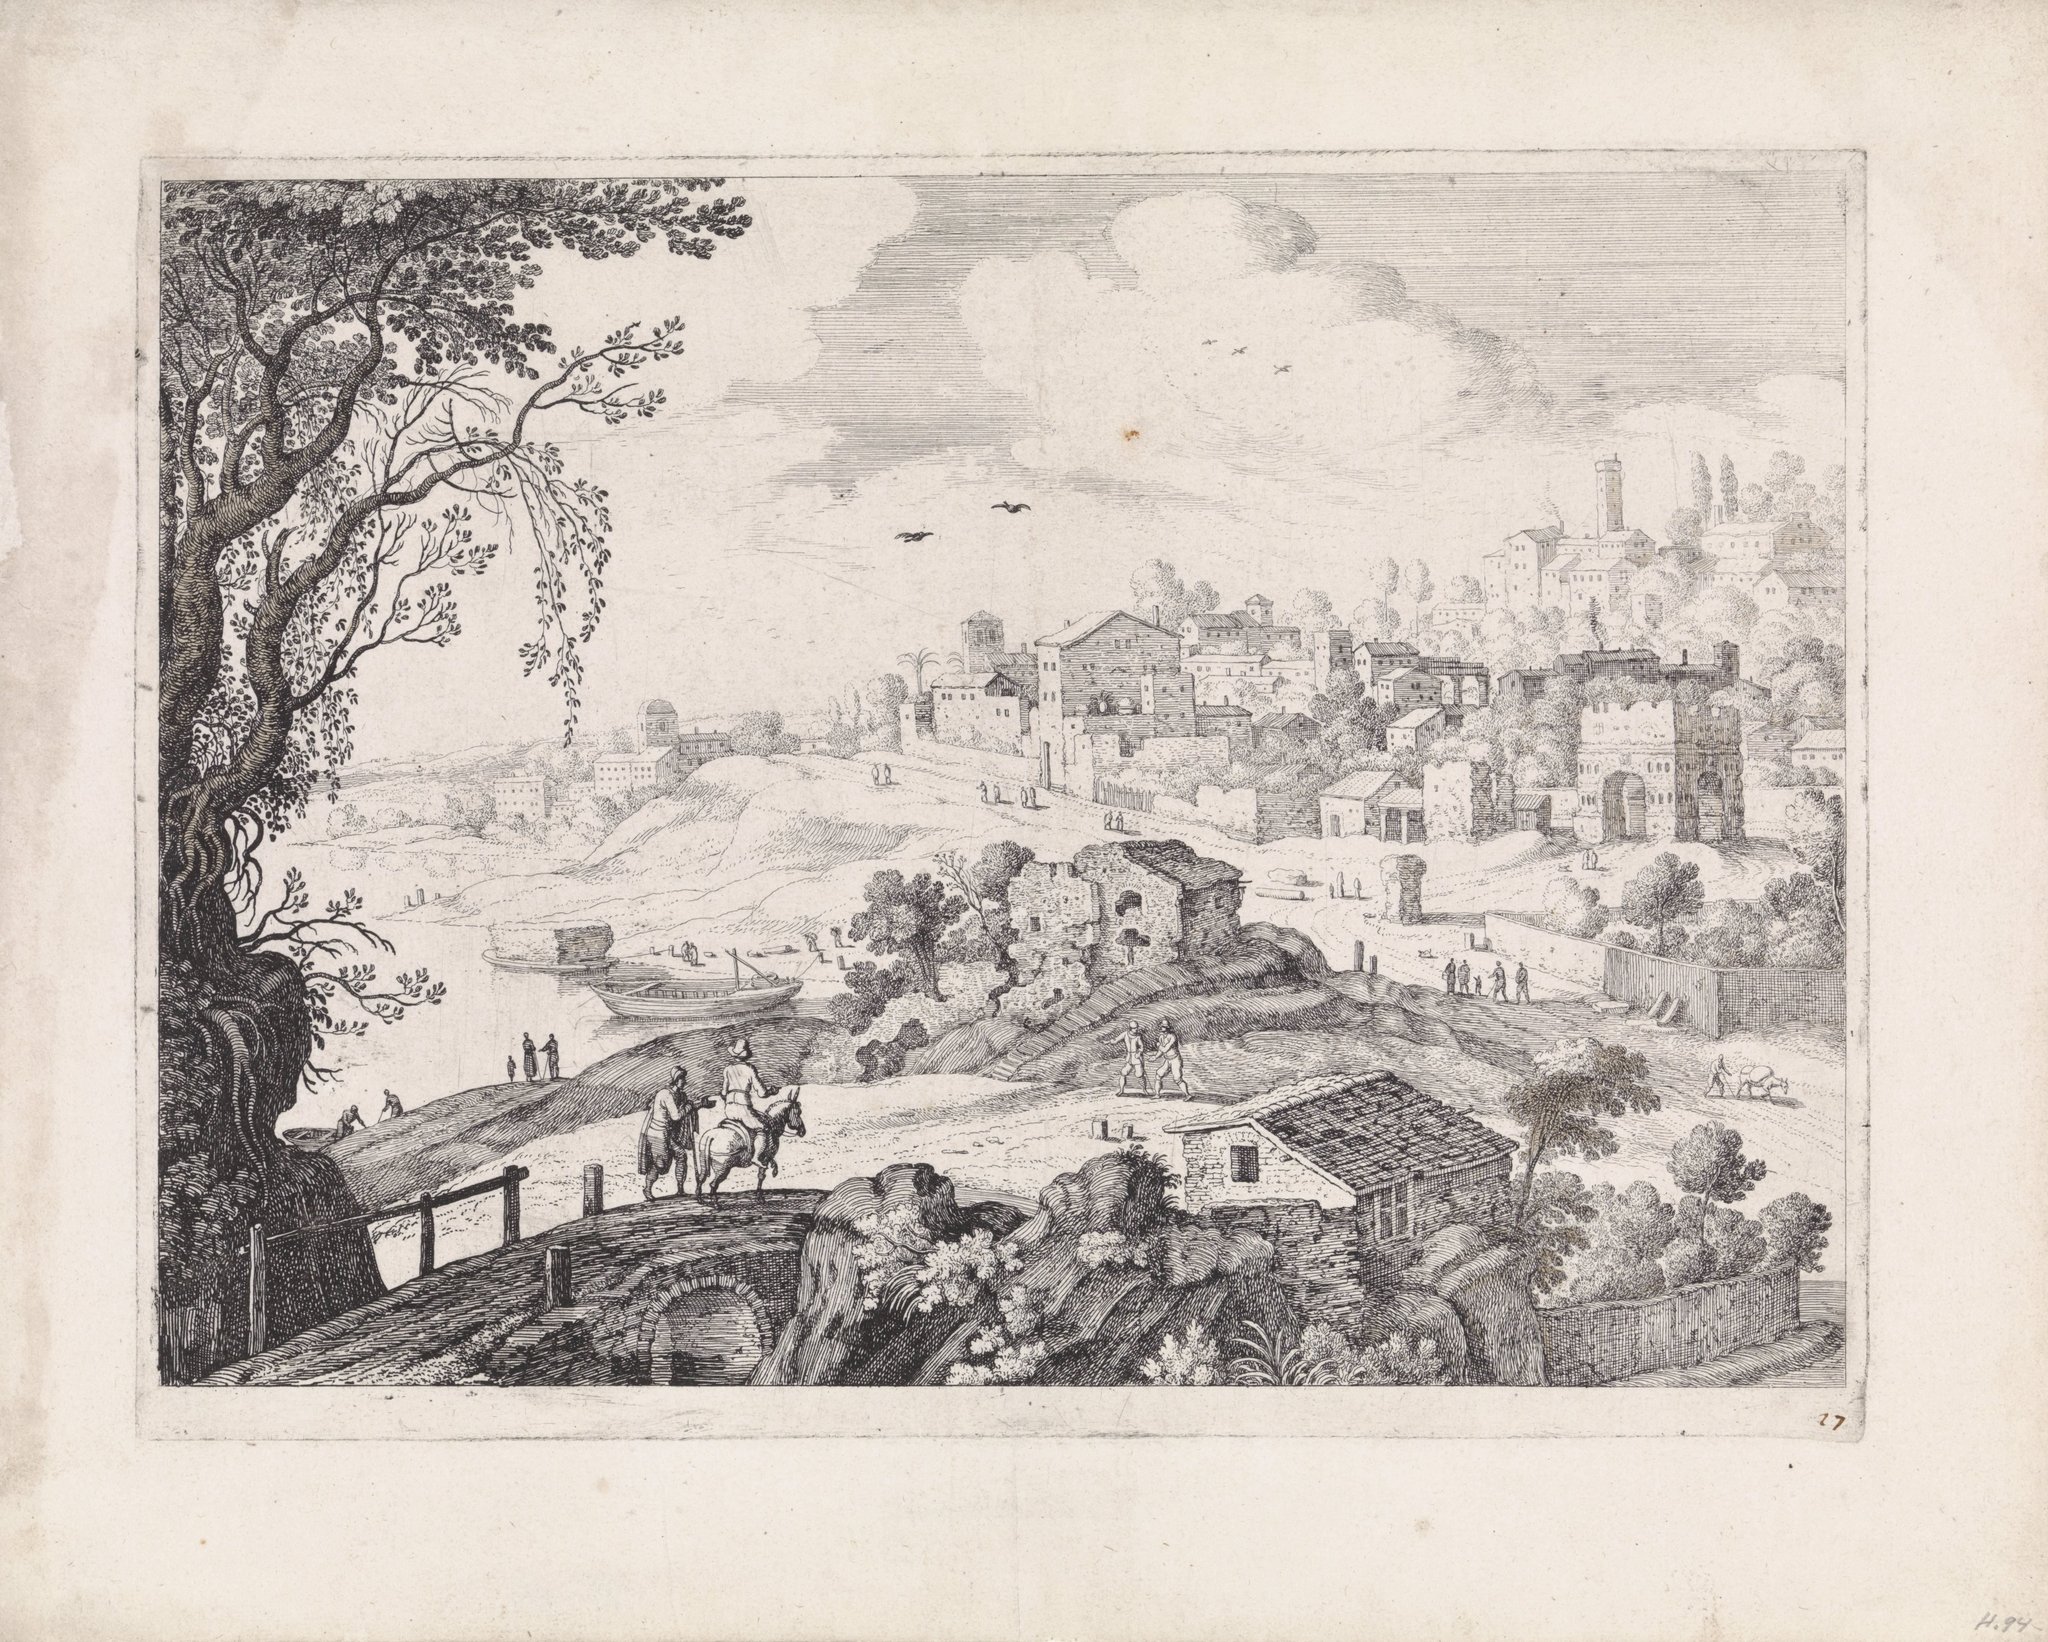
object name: print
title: Italiaans landschap met een stad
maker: guilliam van nieulandt (ii)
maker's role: draughtsman, print maker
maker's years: 1584-1635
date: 1594-1635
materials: paper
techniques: engraving, etching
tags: riding a horse, ass, or mule; rider, horseman, city-view in general; 'veduta'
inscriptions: inscription: ‘27’, collector's mark: Lugt 2760, collector's mark: Lugt 2228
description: In een Italiaans landschap ligt rechts een stad aan het water. Links op de voorgrond rijdt een ruiter over een stenen brug. De ruiter is in gesprek met de wandelaar naast hem. Prent uit een serie Italiaanse landschappen.